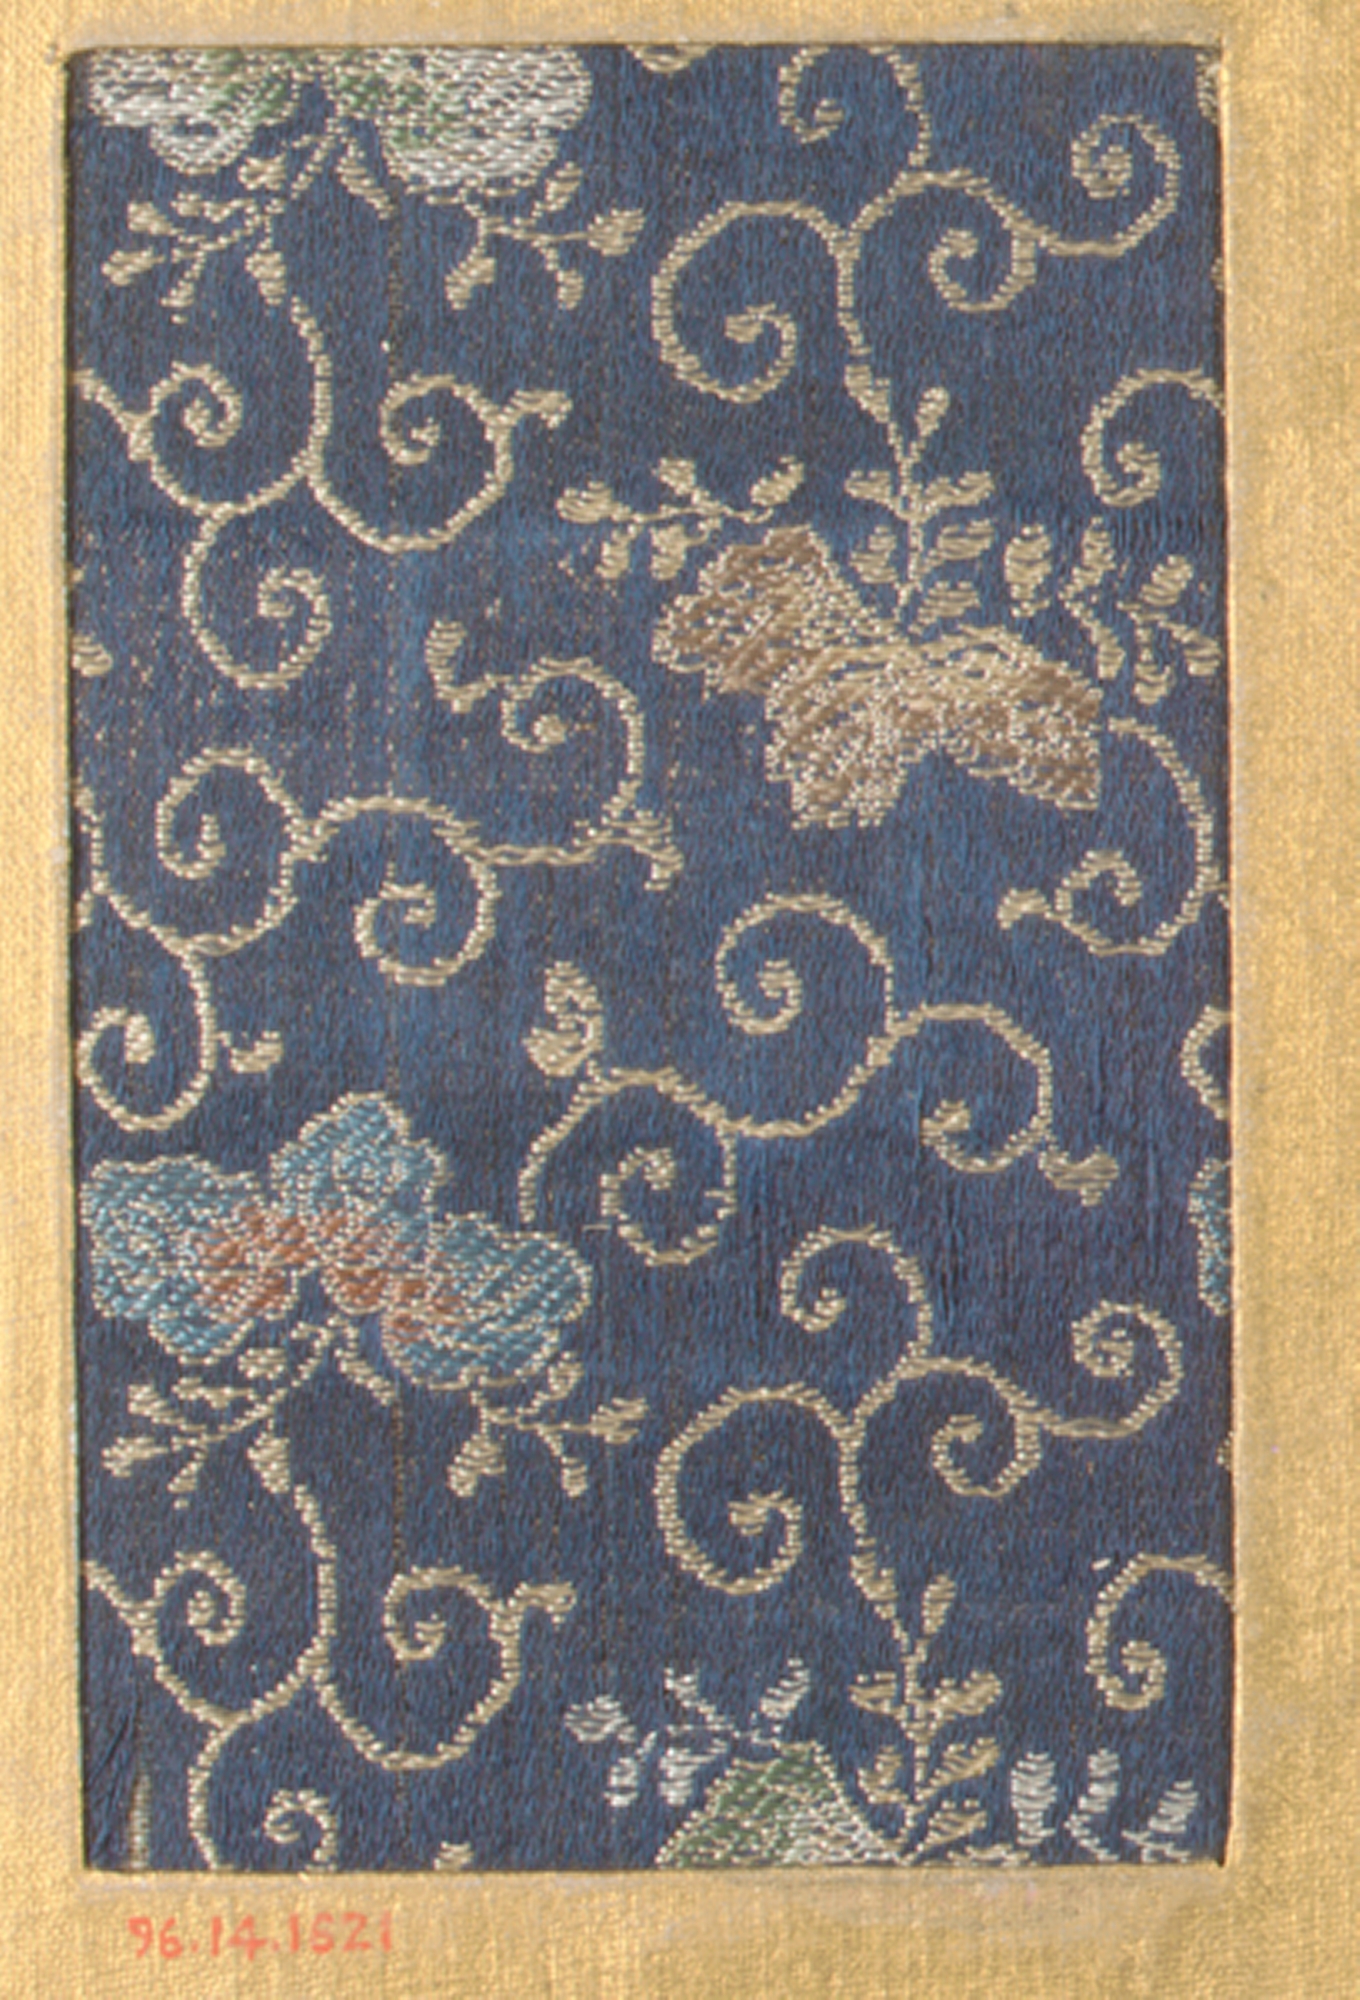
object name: piece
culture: japanese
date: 1701-1900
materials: silk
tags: flowers